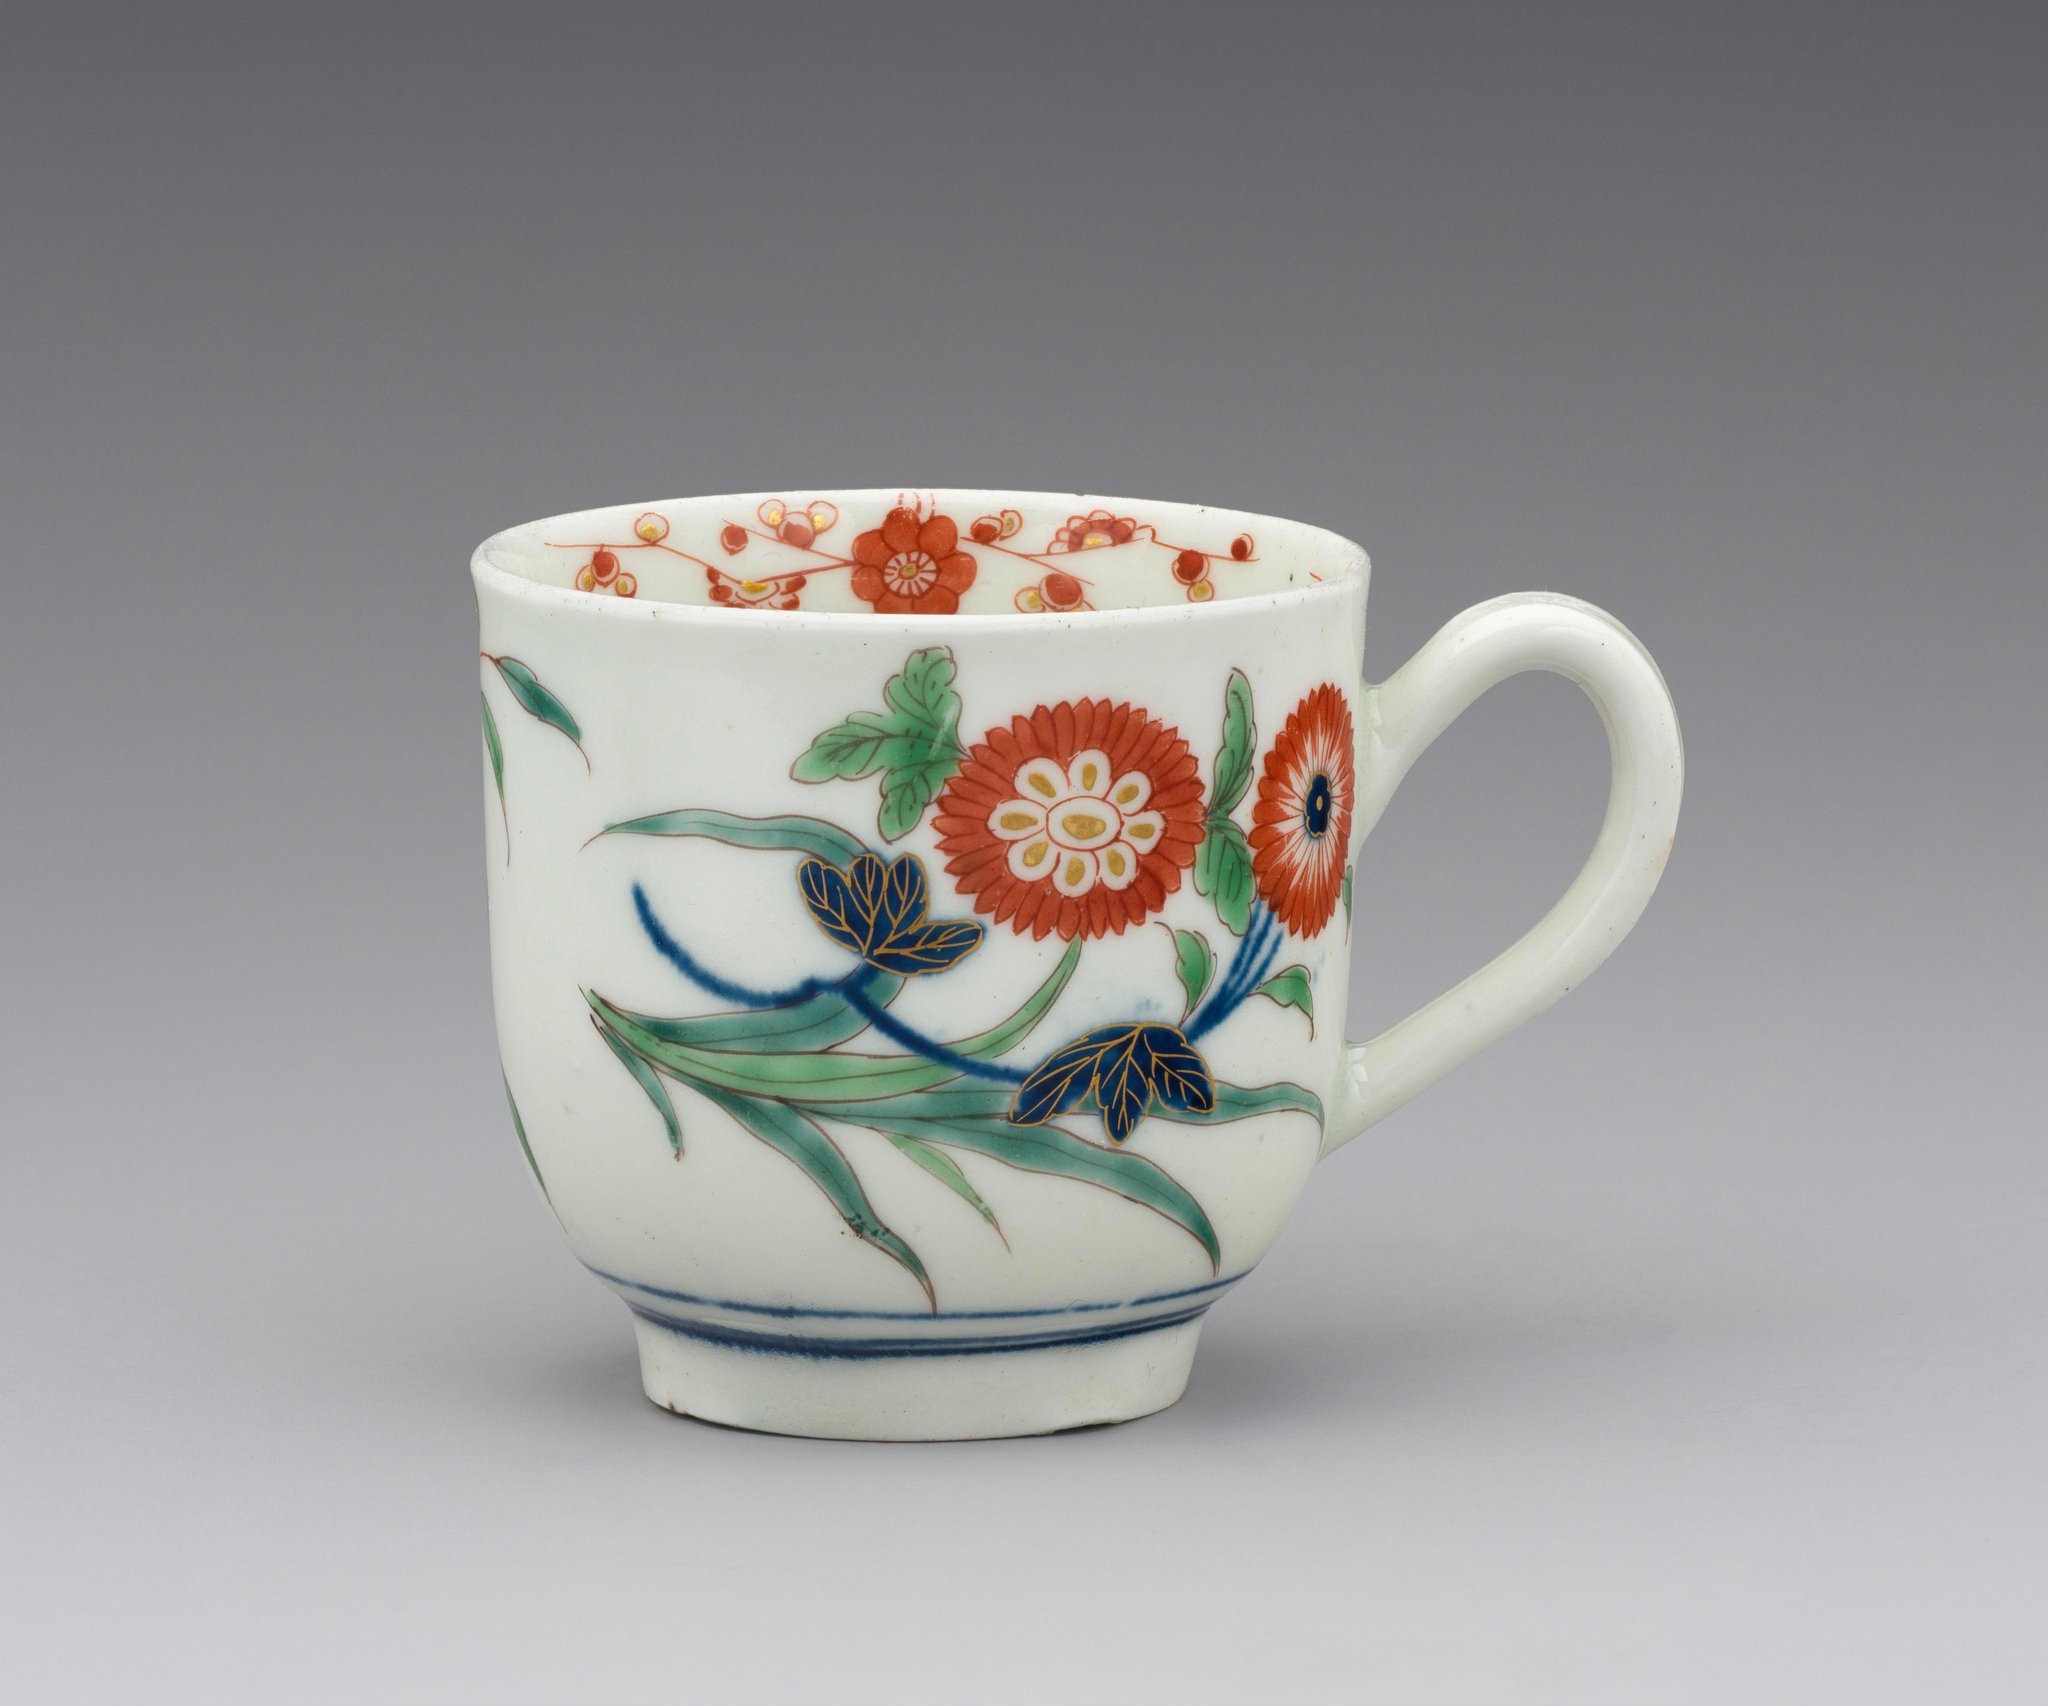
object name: chocolate cup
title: Chocolate cup (part of a service)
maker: worcester factory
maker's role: factory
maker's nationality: british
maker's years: 1751-2008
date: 1765-1770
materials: soft paste porcelain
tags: flowers